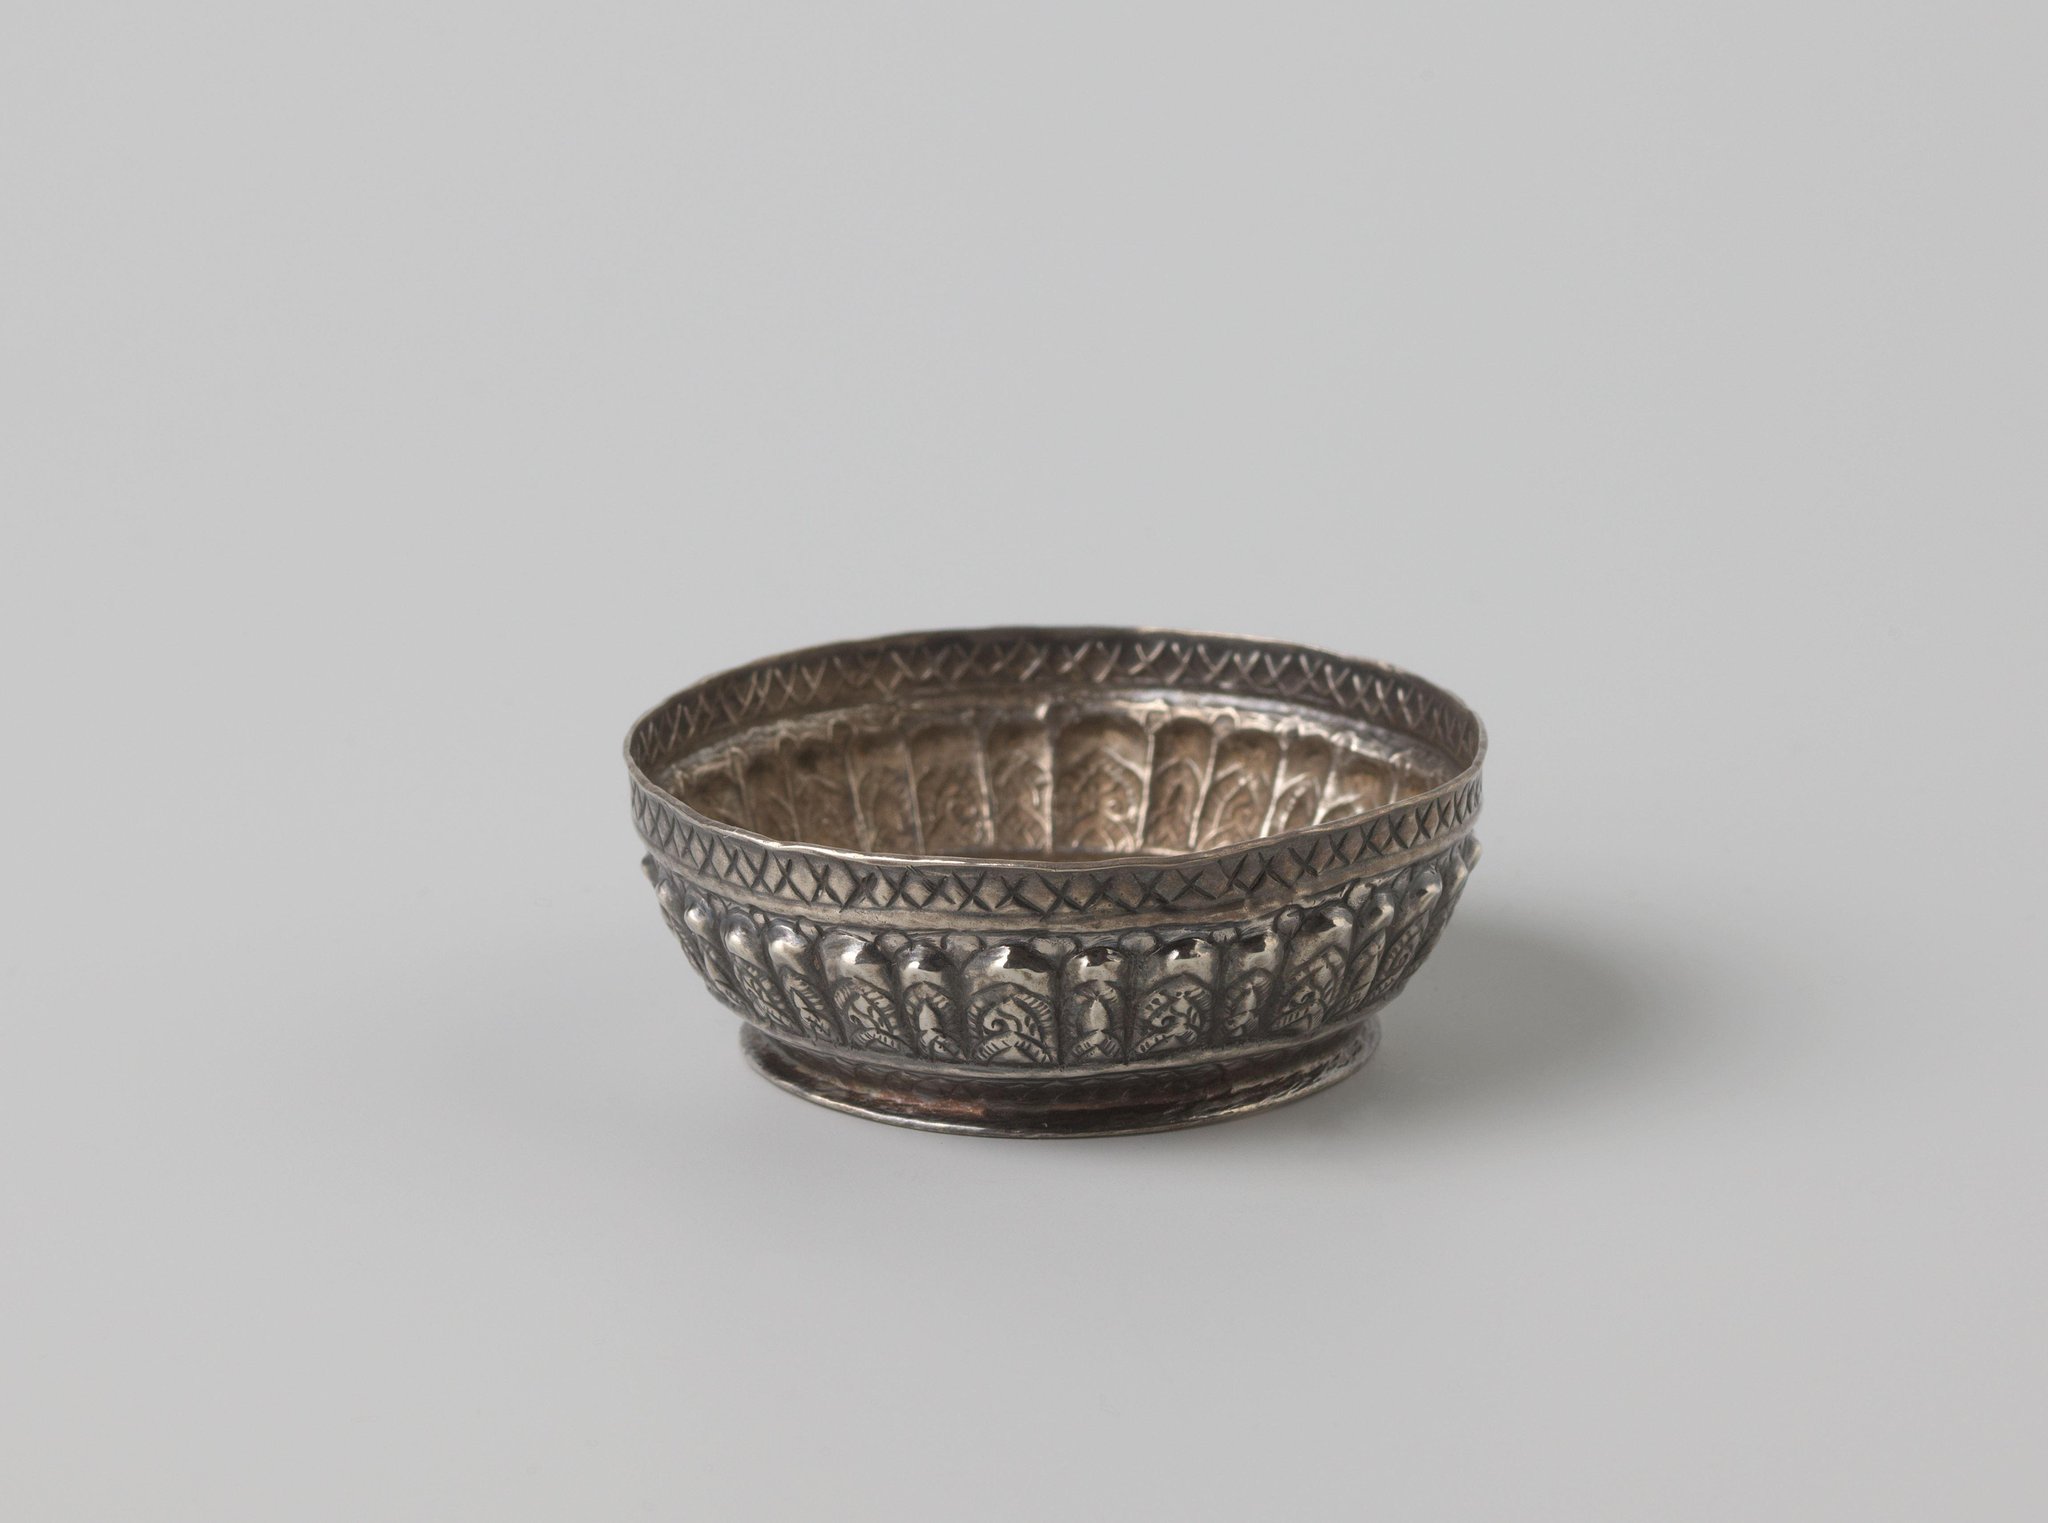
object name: bowl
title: Kom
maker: Anonymous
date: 1600-1900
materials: silver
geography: indonesia